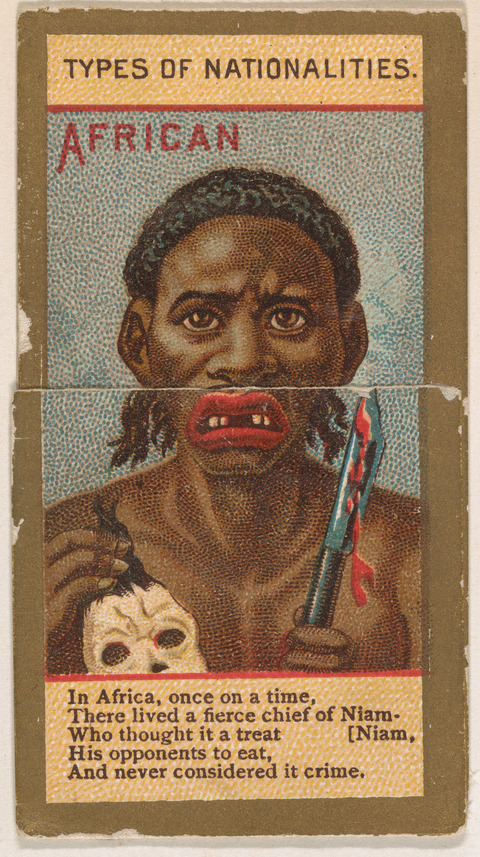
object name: print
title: African, from Types of Nationalities (N240) issued by Kinney Bros.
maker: kinney brothers tobacco company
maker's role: publisher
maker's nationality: american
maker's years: 1869-2011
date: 1890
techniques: color lithograph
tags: men